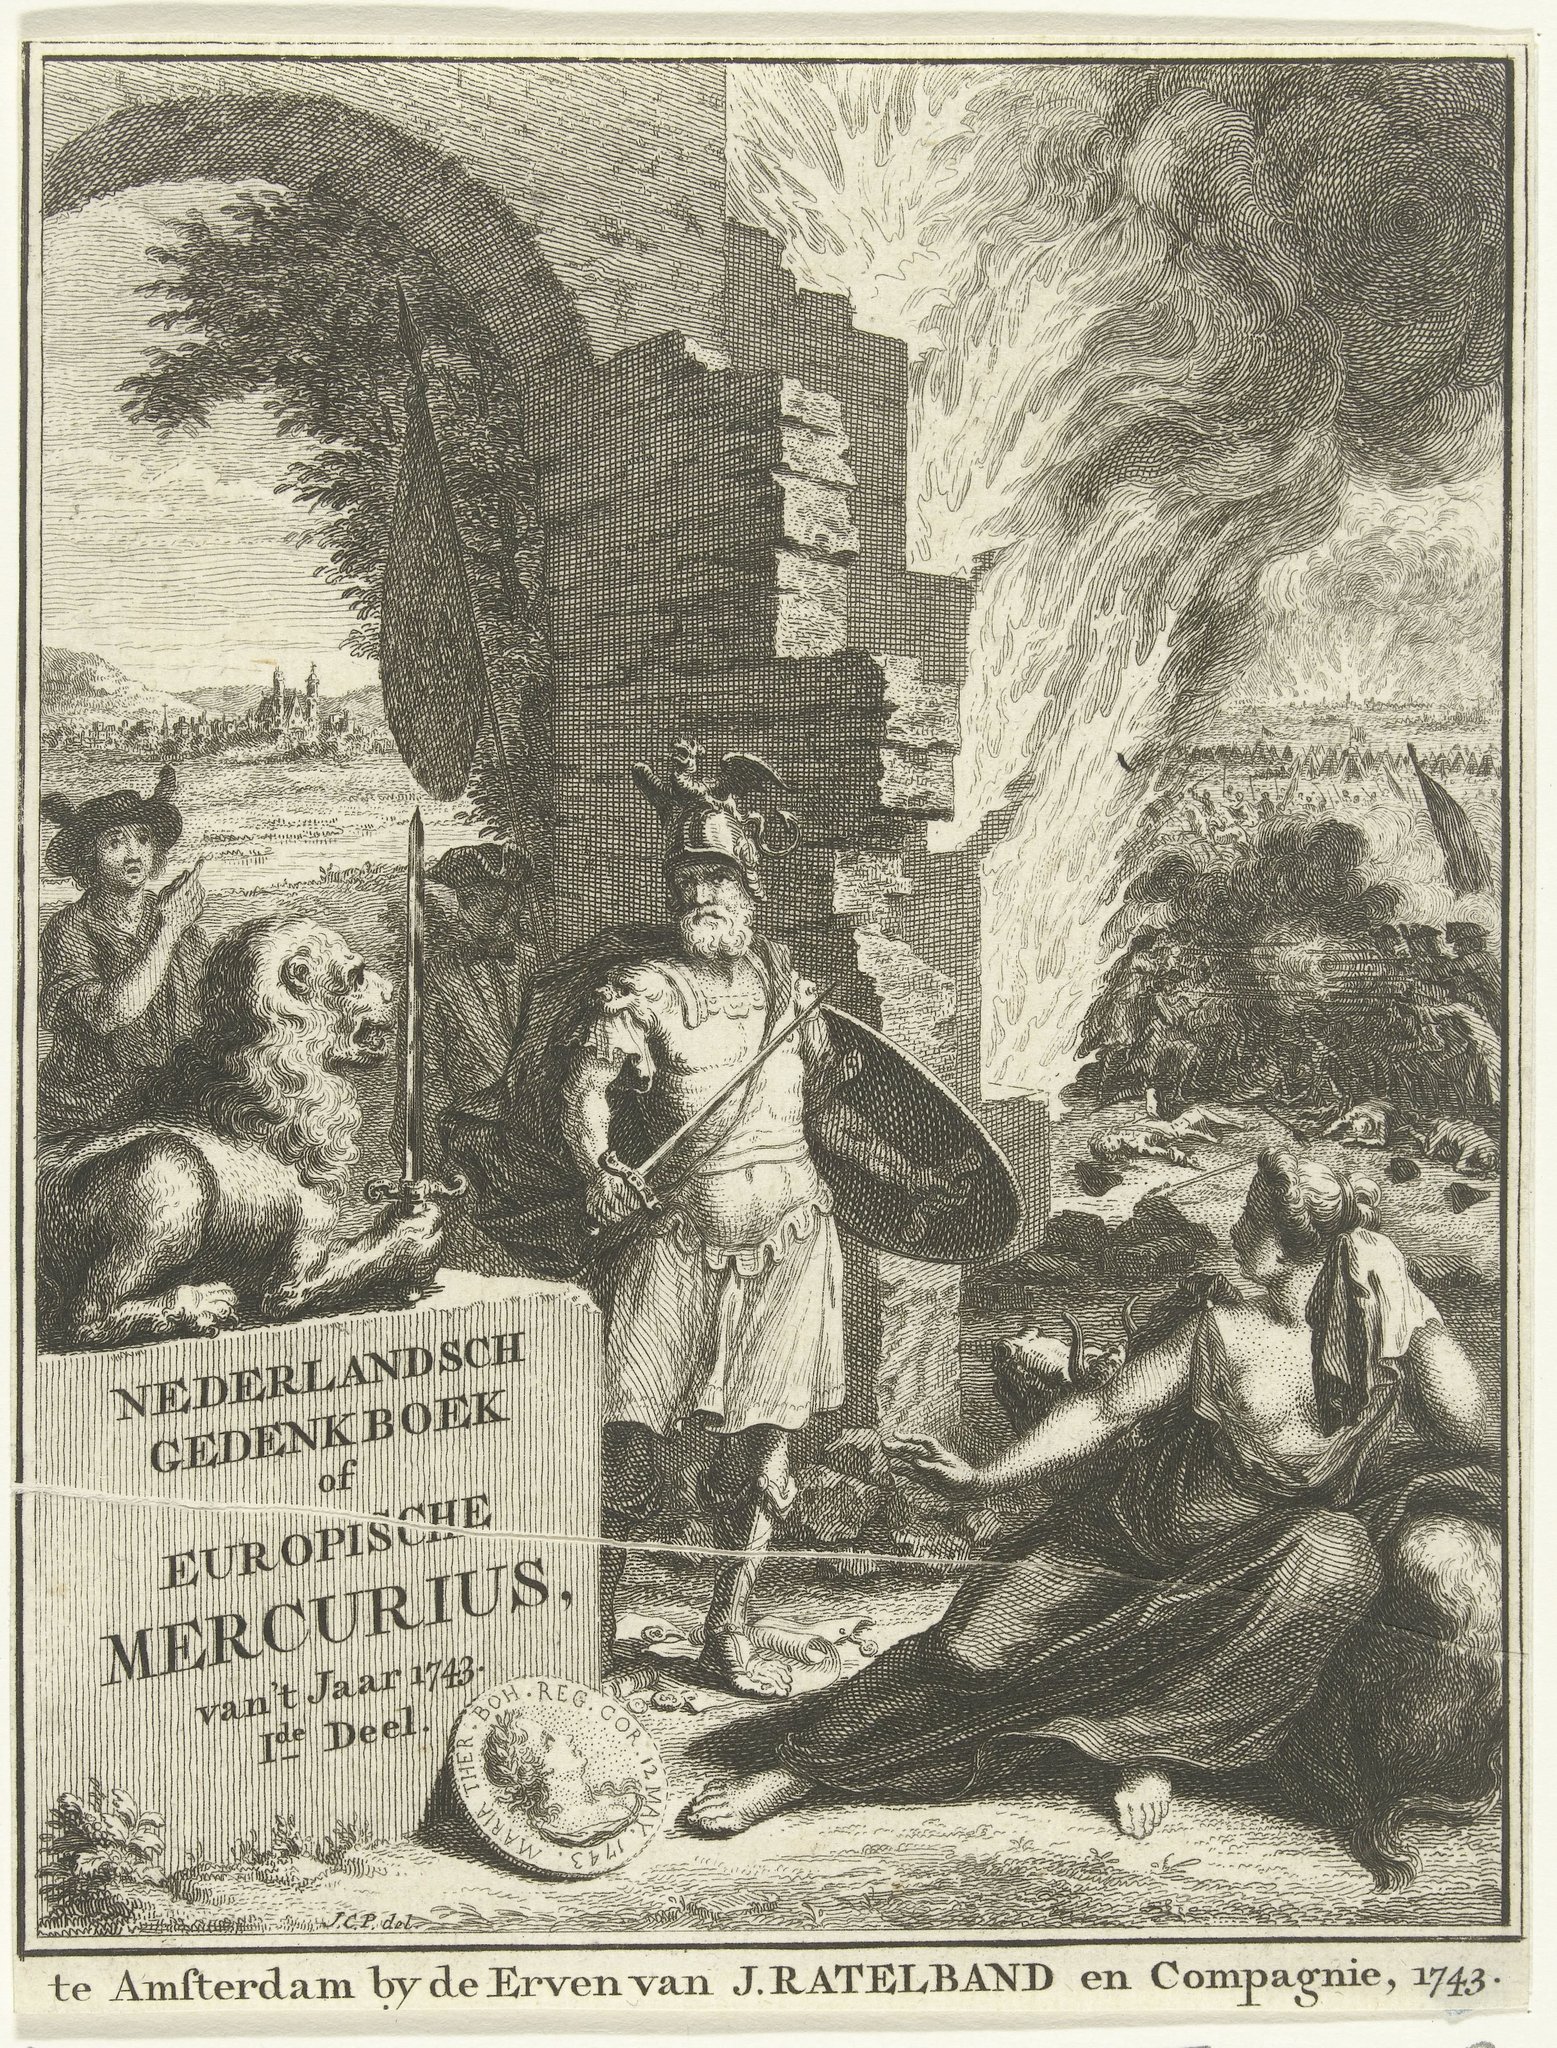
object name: titelblad, titelpagina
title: Titelpagina voor de Europische Mercurius van 1743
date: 1743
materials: paper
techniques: engraving, etching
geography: northern netherlands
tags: vienna, maria theresia (rooms-duits keizerin)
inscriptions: collector's mark: Lugt 2228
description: Titelpagina voor het Nederlandsch Gedenkboek of Europische Mercurius, over het jaar 1743. De Nederlandse Leeuw met zwaard op een voetstuk voor Mars, een portret van Maria Theresia op de grond, rechts de wenende Europa met stier, op de achtergrond de vlammen van de oorlog.